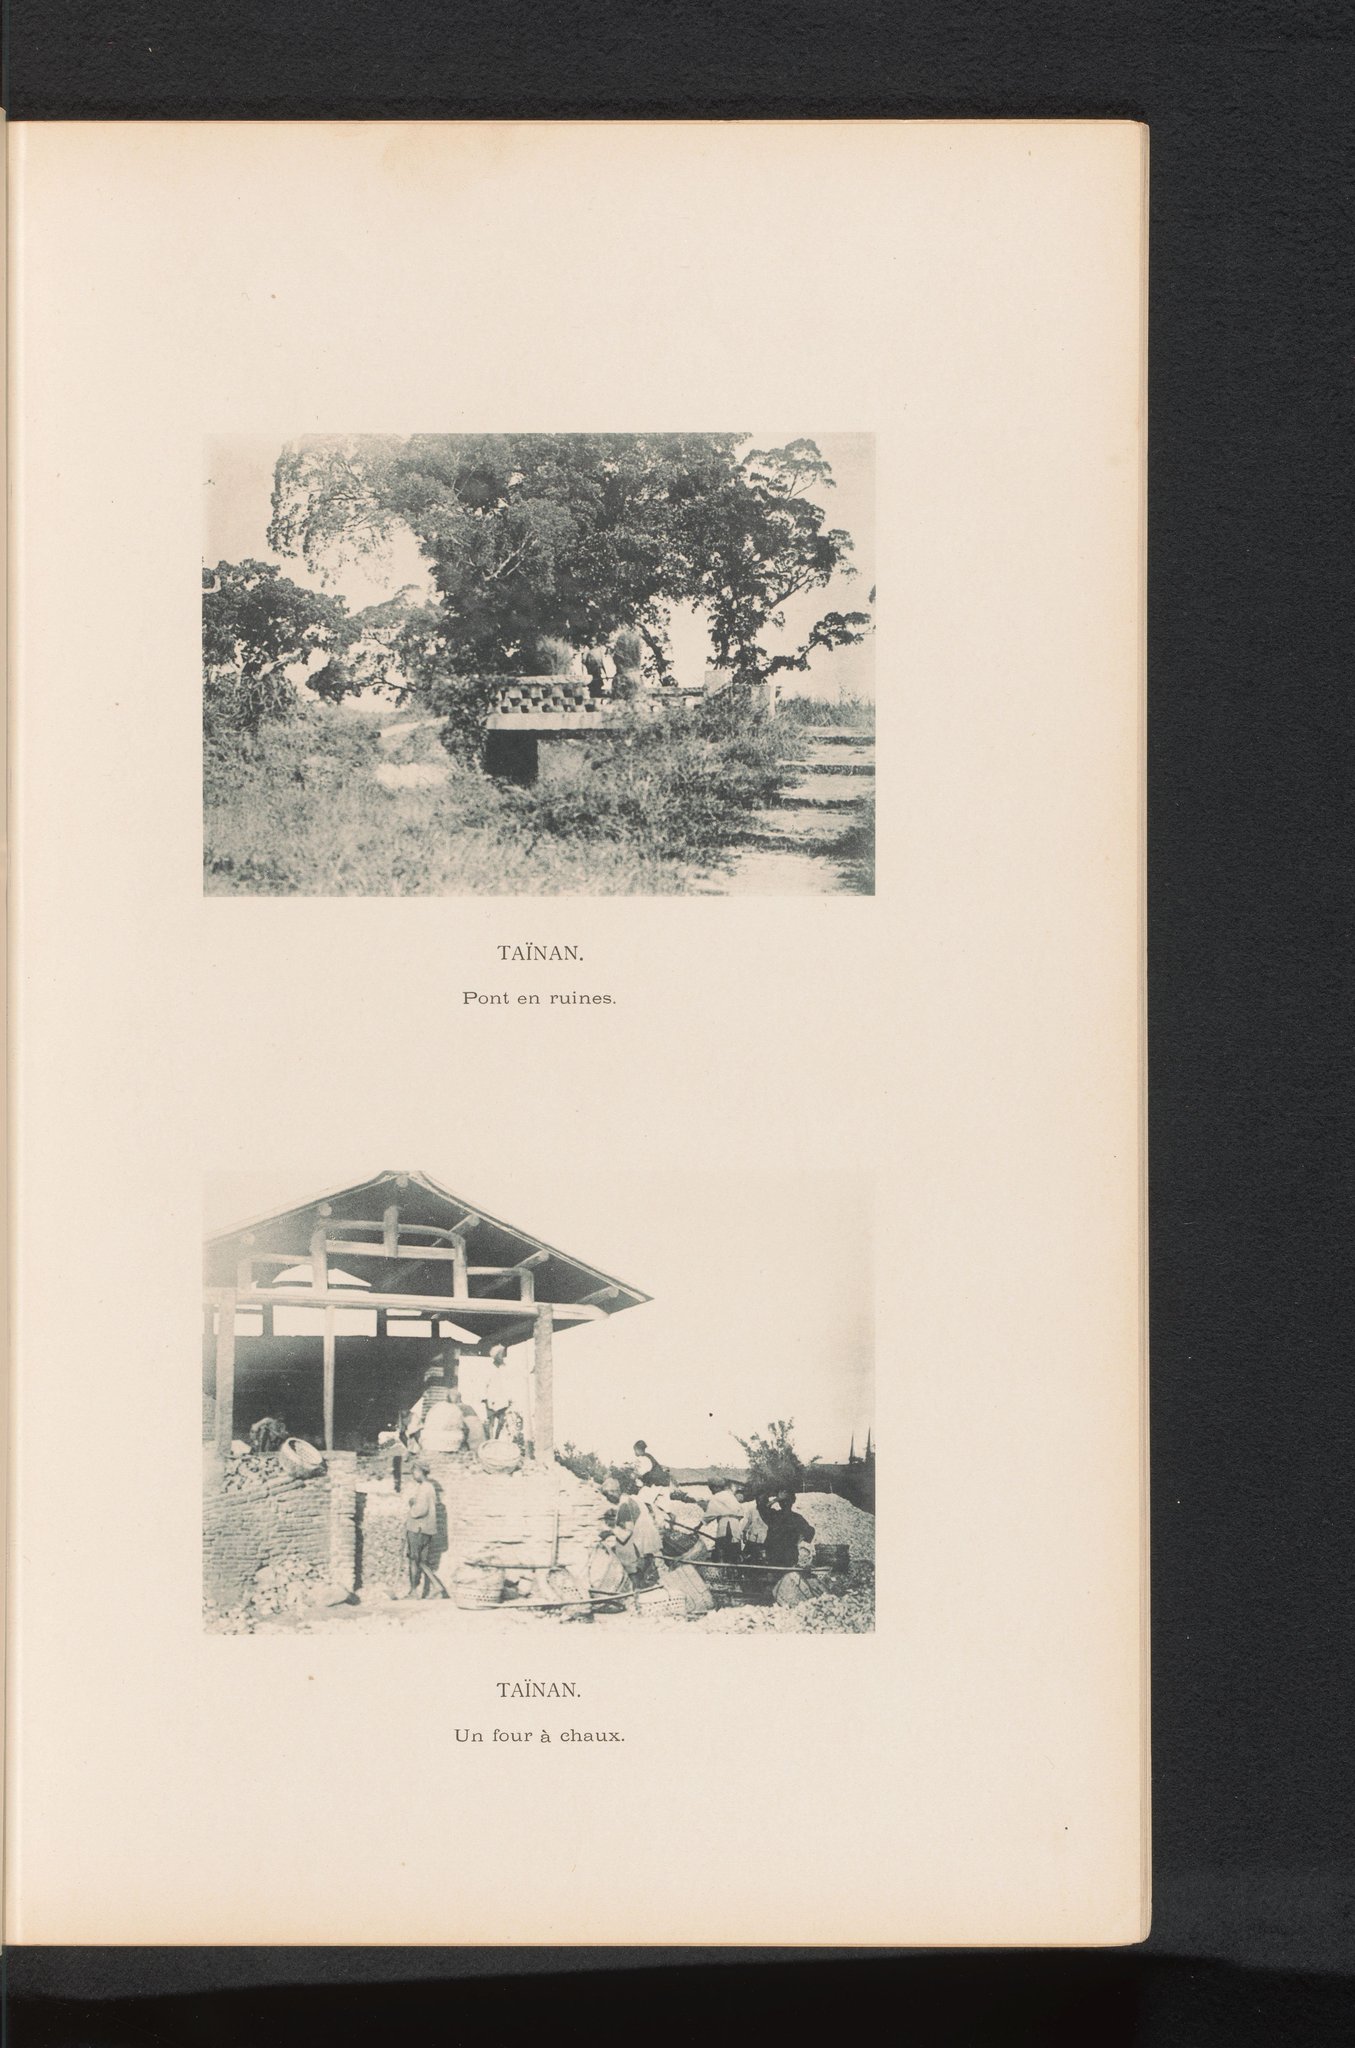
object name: page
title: Gezicht op een vervallen brug en een hoogoven te Tainan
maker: Anonymous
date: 1891-1896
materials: paper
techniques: photograph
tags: blast-furnace, bridge (+ one person ~ traffic and transport), landscape with ruins